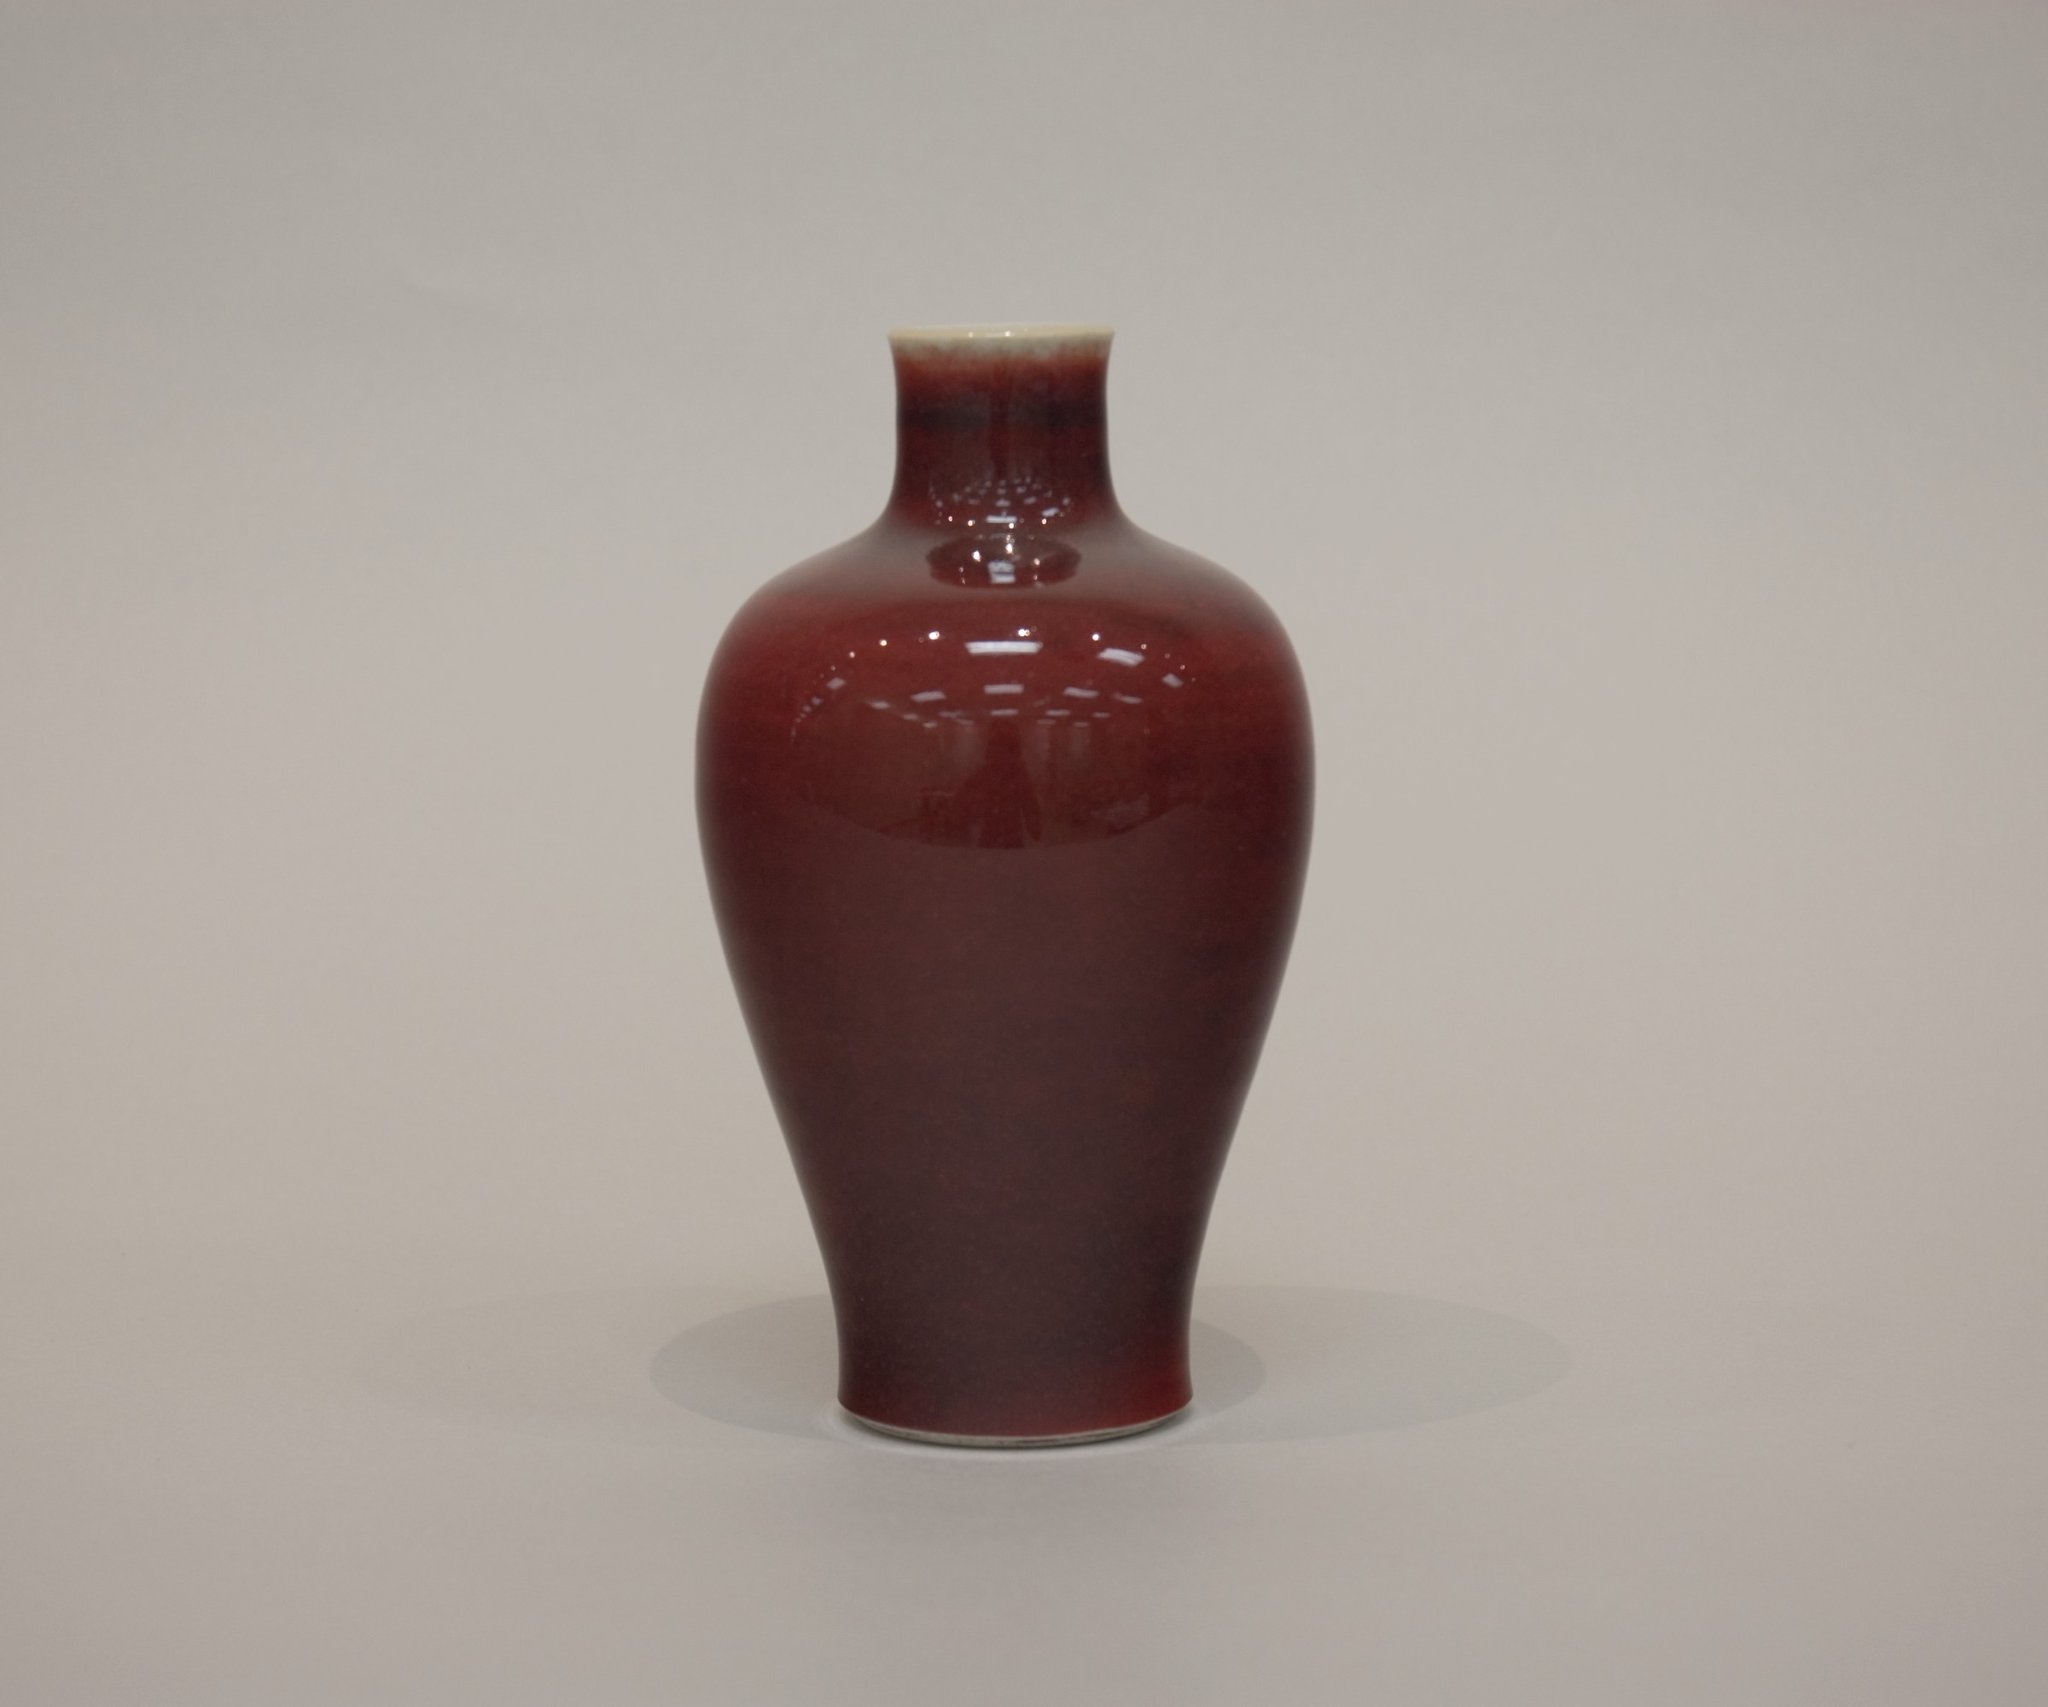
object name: vase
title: Prunus Vase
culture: chinese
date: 1662-1722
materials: porcelain